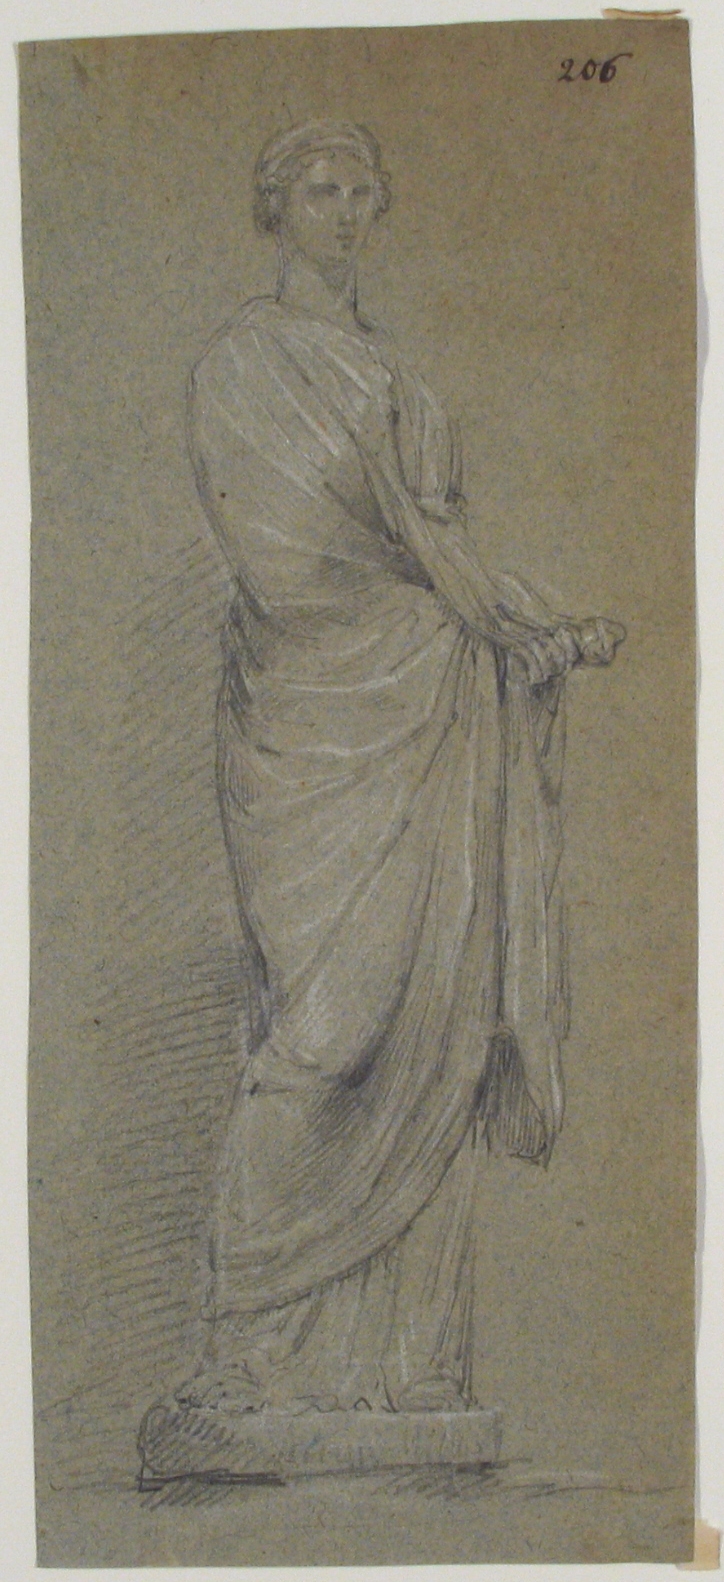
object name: drawing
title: Drawing of Female Statue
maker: anonymous, french, 18th century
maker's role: artist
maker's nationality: french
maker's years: 1700-1800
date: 1701-1800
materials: chalk, paper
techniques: heightening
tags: women